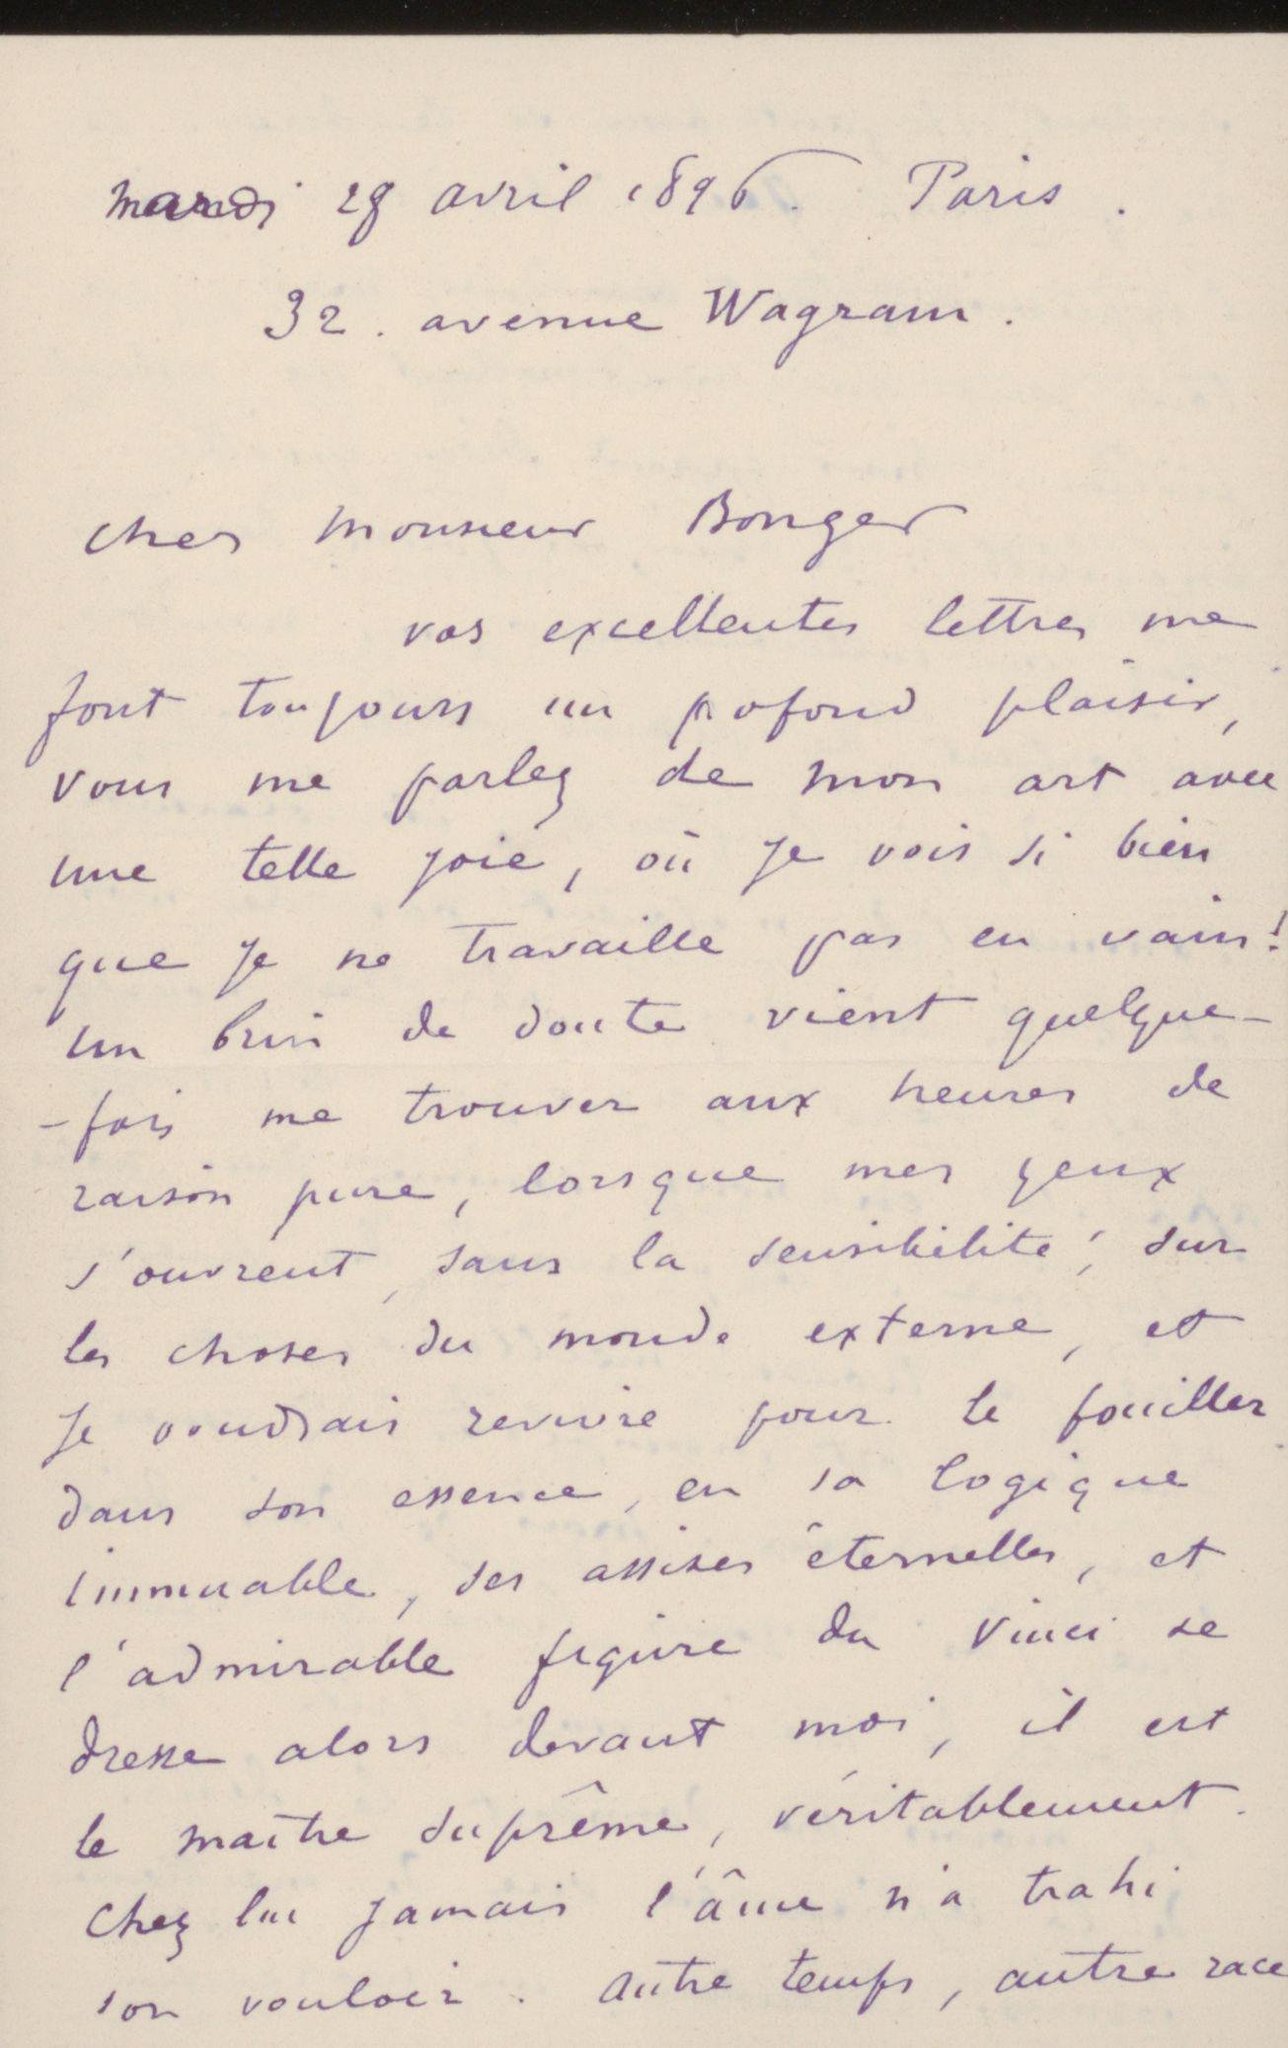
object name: letter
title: Brief aan Andries Bonger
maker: odilon redon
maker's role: draughtsman, painter, print maker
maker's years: 1840-1916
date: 1896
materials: ink, paper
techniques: pen, writing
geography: paris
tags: liège, paris, painter, print maker, draughtsman, paul cézanne, andries bonger, artist, leonardo da vinci, stéphane mallarmé, arnhem, the hague, publisher, martinus nijhoff, drawing, music, photography, cinematography, the graphic arts, historical persons (portraits and scenes from the life), london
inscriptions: watermark